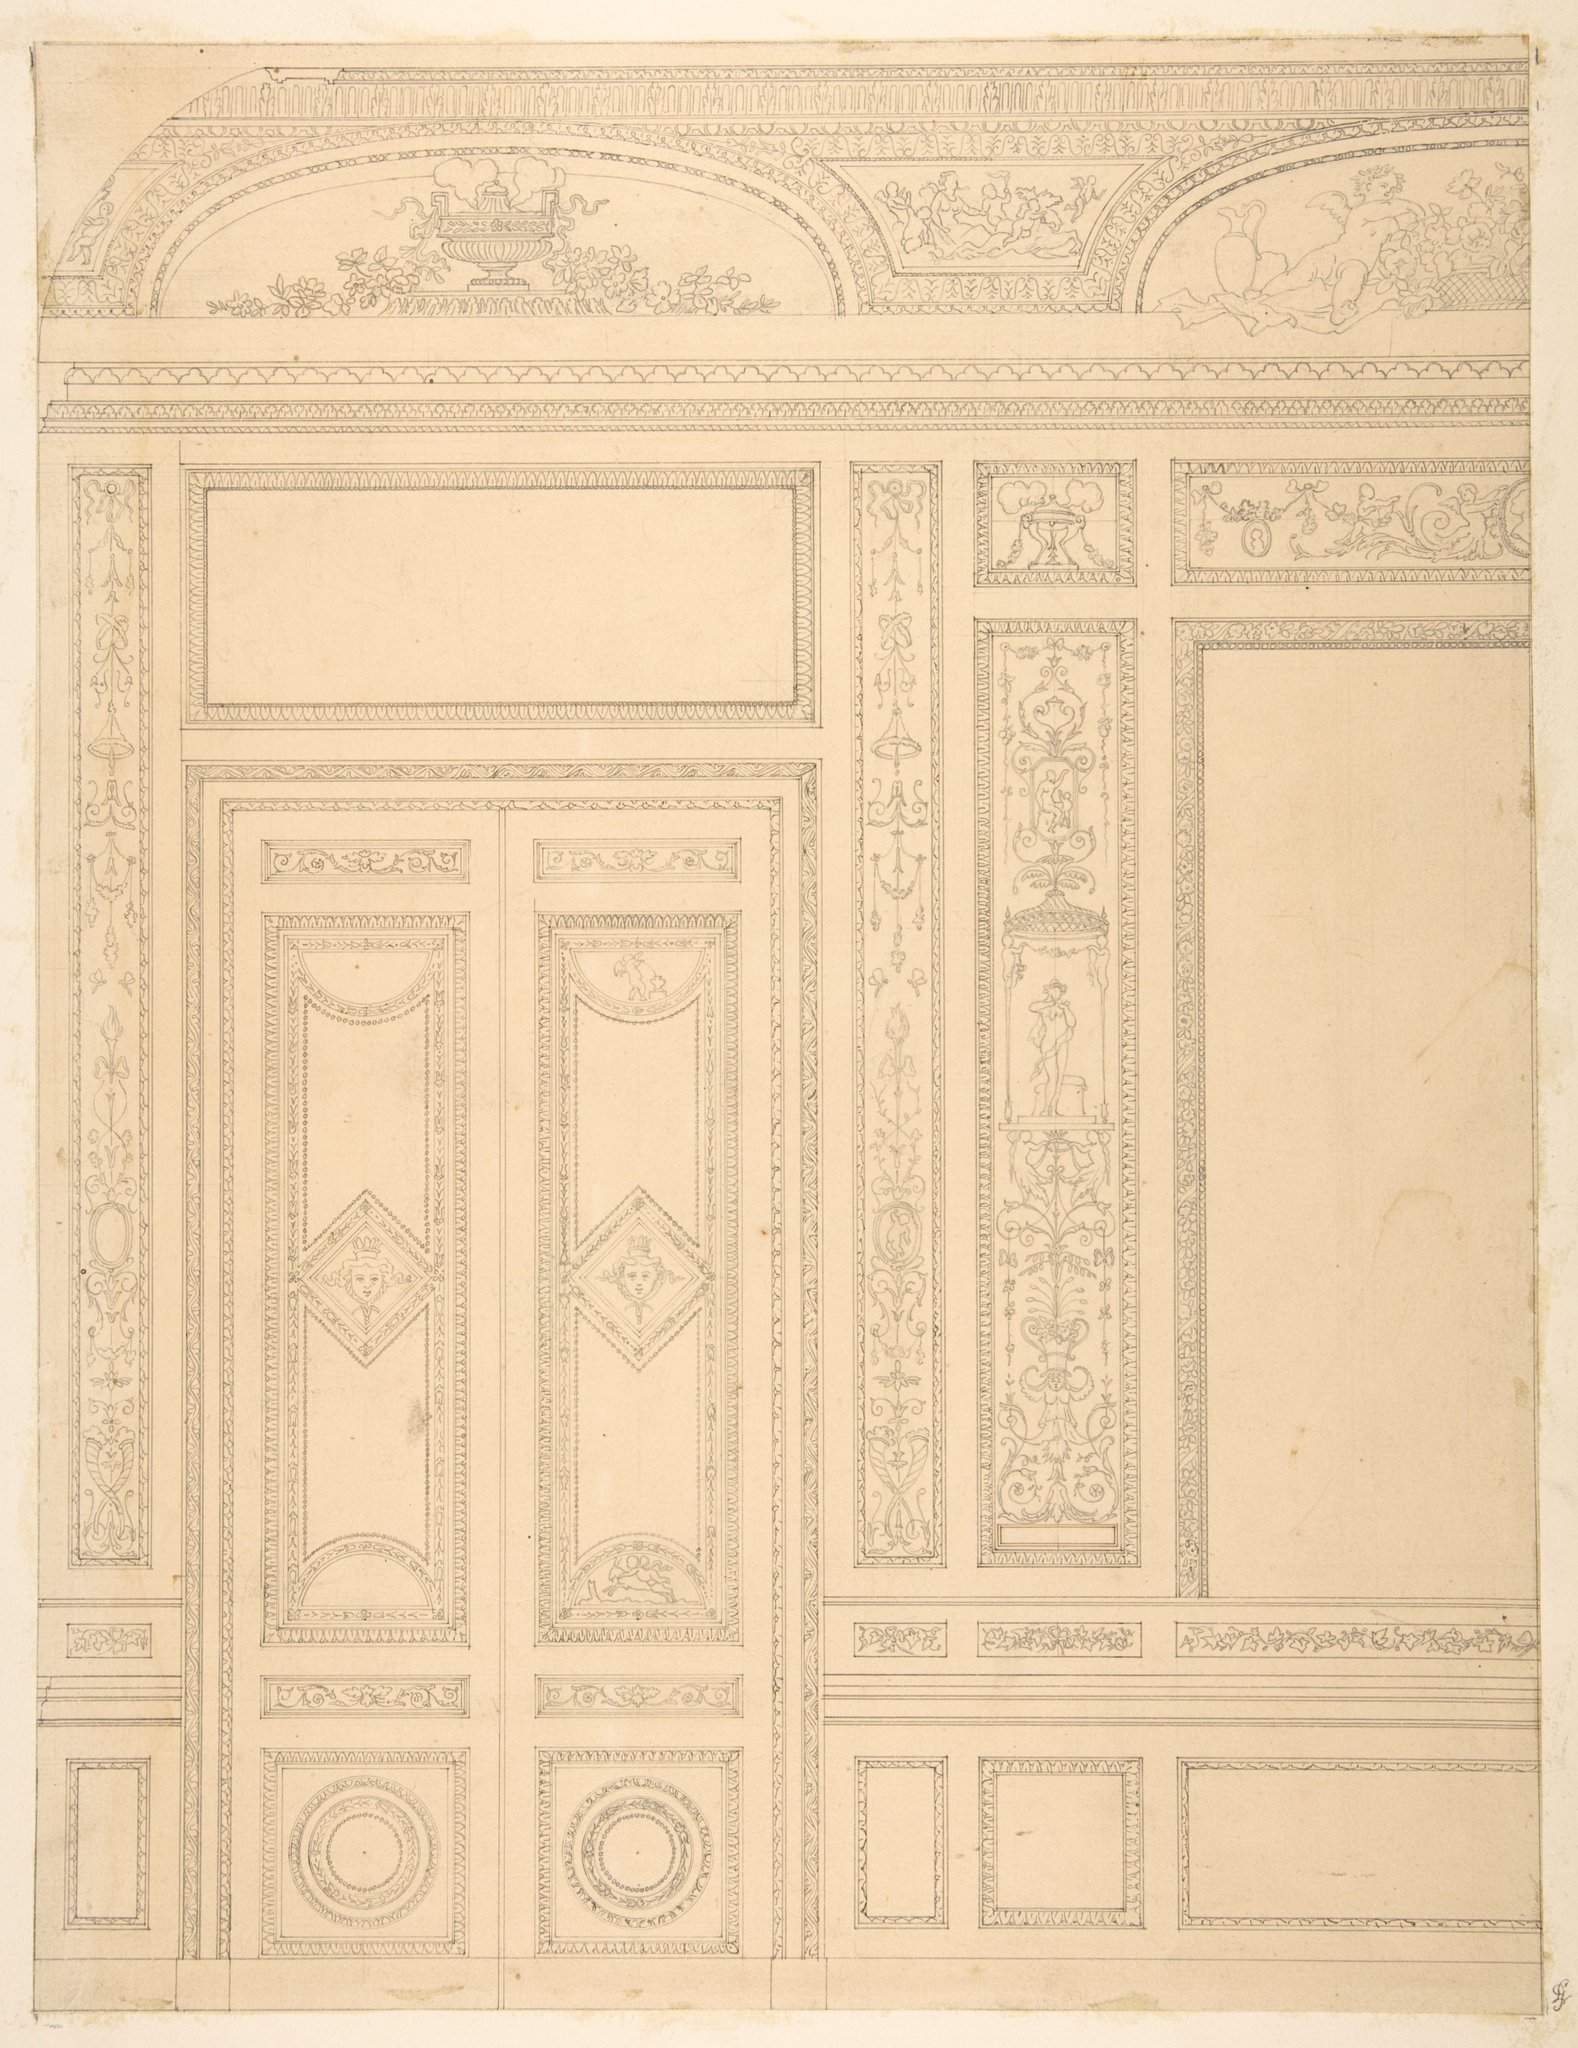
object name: drawing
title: Elevation of an interior showing a paneled wall and double doors decorated in rococco sty.e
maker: jules-edmond-charles lachaise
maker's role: artist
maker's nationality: french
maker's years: 1897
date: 1830-1897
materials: graphite, paper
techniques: inlay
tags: architecture,interiors